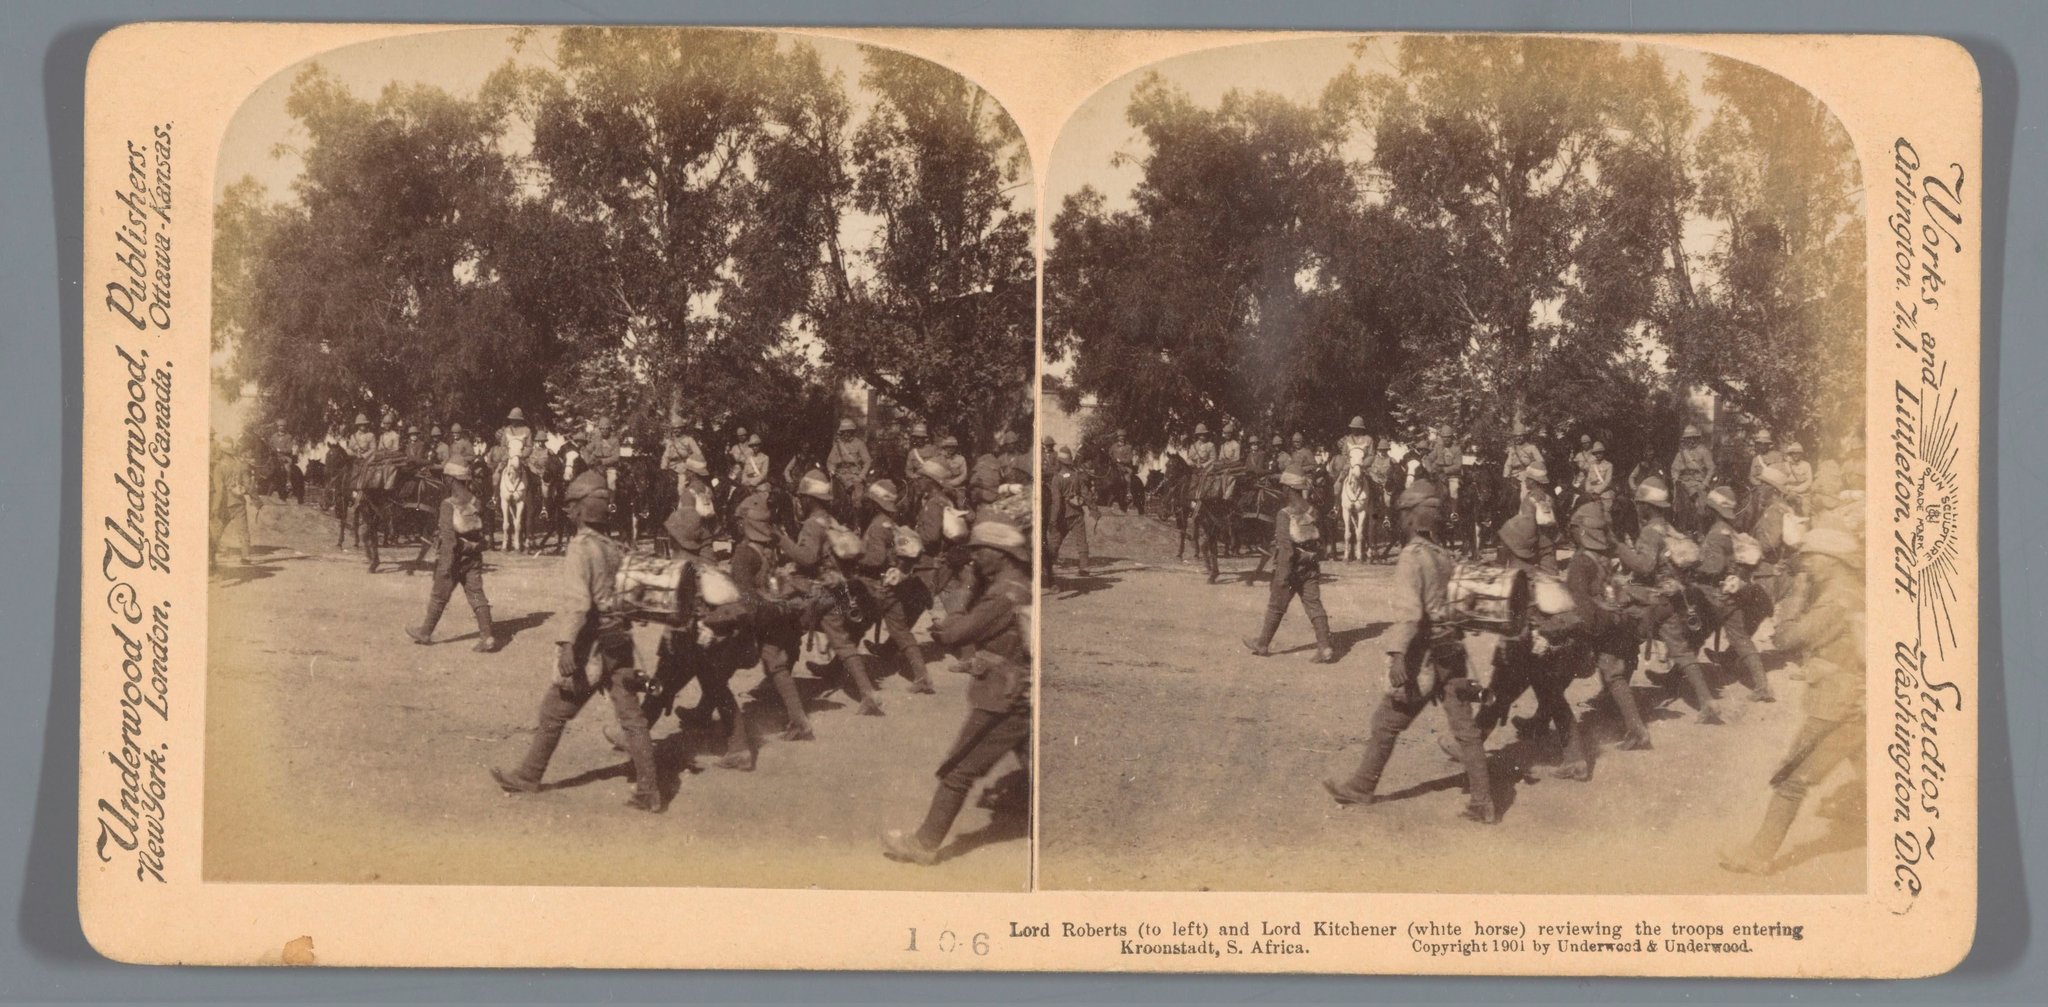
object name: stereograph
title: Lord Roberts (to left) and Lord Kitchener (white horse) reviewing the troops entering Kroonstadt, S. Africa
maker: Anonymous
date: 1901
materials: cardboard, paper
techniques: albumen print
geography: kroonstad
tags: horatio herbert kitchener, marching away (troops), review, inspection (of company, unit, troop)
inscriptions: number: ‘106’, inscription: ‘Works and Studios ~/ Arlington, N.J. Littleton, N.H. Washington, D.C.’, inscription, copyright notice: ‘Copyright 1901 by Underwood & Underwood.’